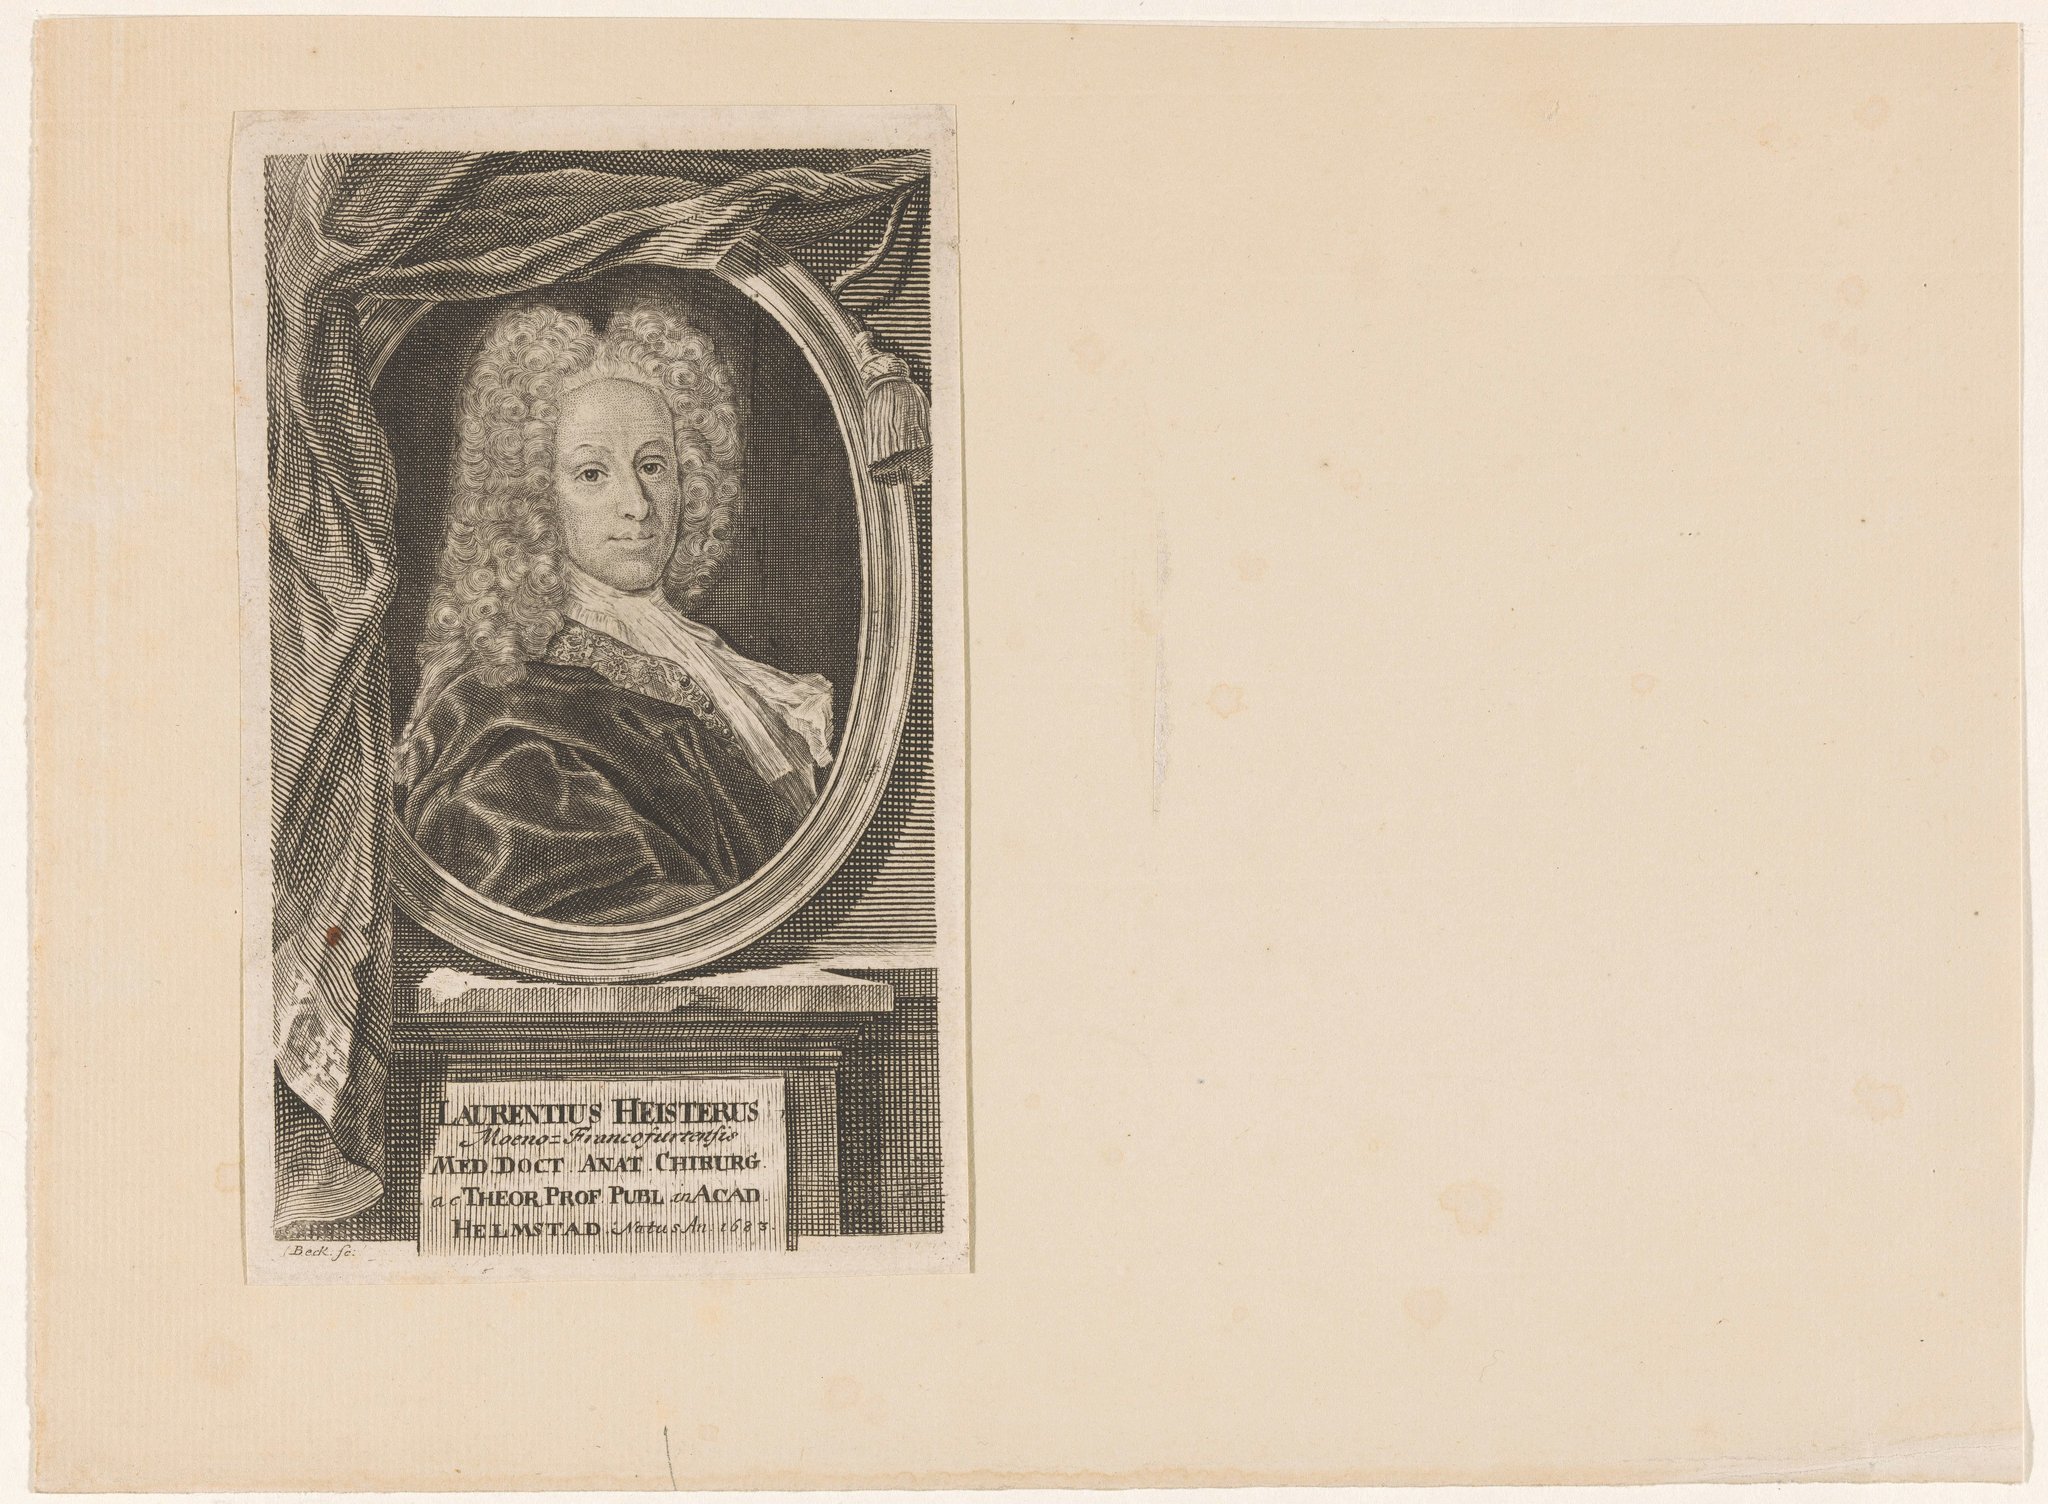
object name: print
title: Portret van Lorenz Heister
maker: anton august beck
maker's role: print maker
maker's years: 1713-1787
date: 1732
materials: paper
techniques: engraving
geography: braunschweig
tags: historical persons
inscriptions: collector's mark: Lugt 2228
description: Prent ook gebruikt in: Heister, Lorenz. Compendium Anatomicum (...) Editio quarta. Dl. 1. Altdorf/Nürnberg: Jobst Wilhelm Kohles & Georg Christoph Weber, 1732.